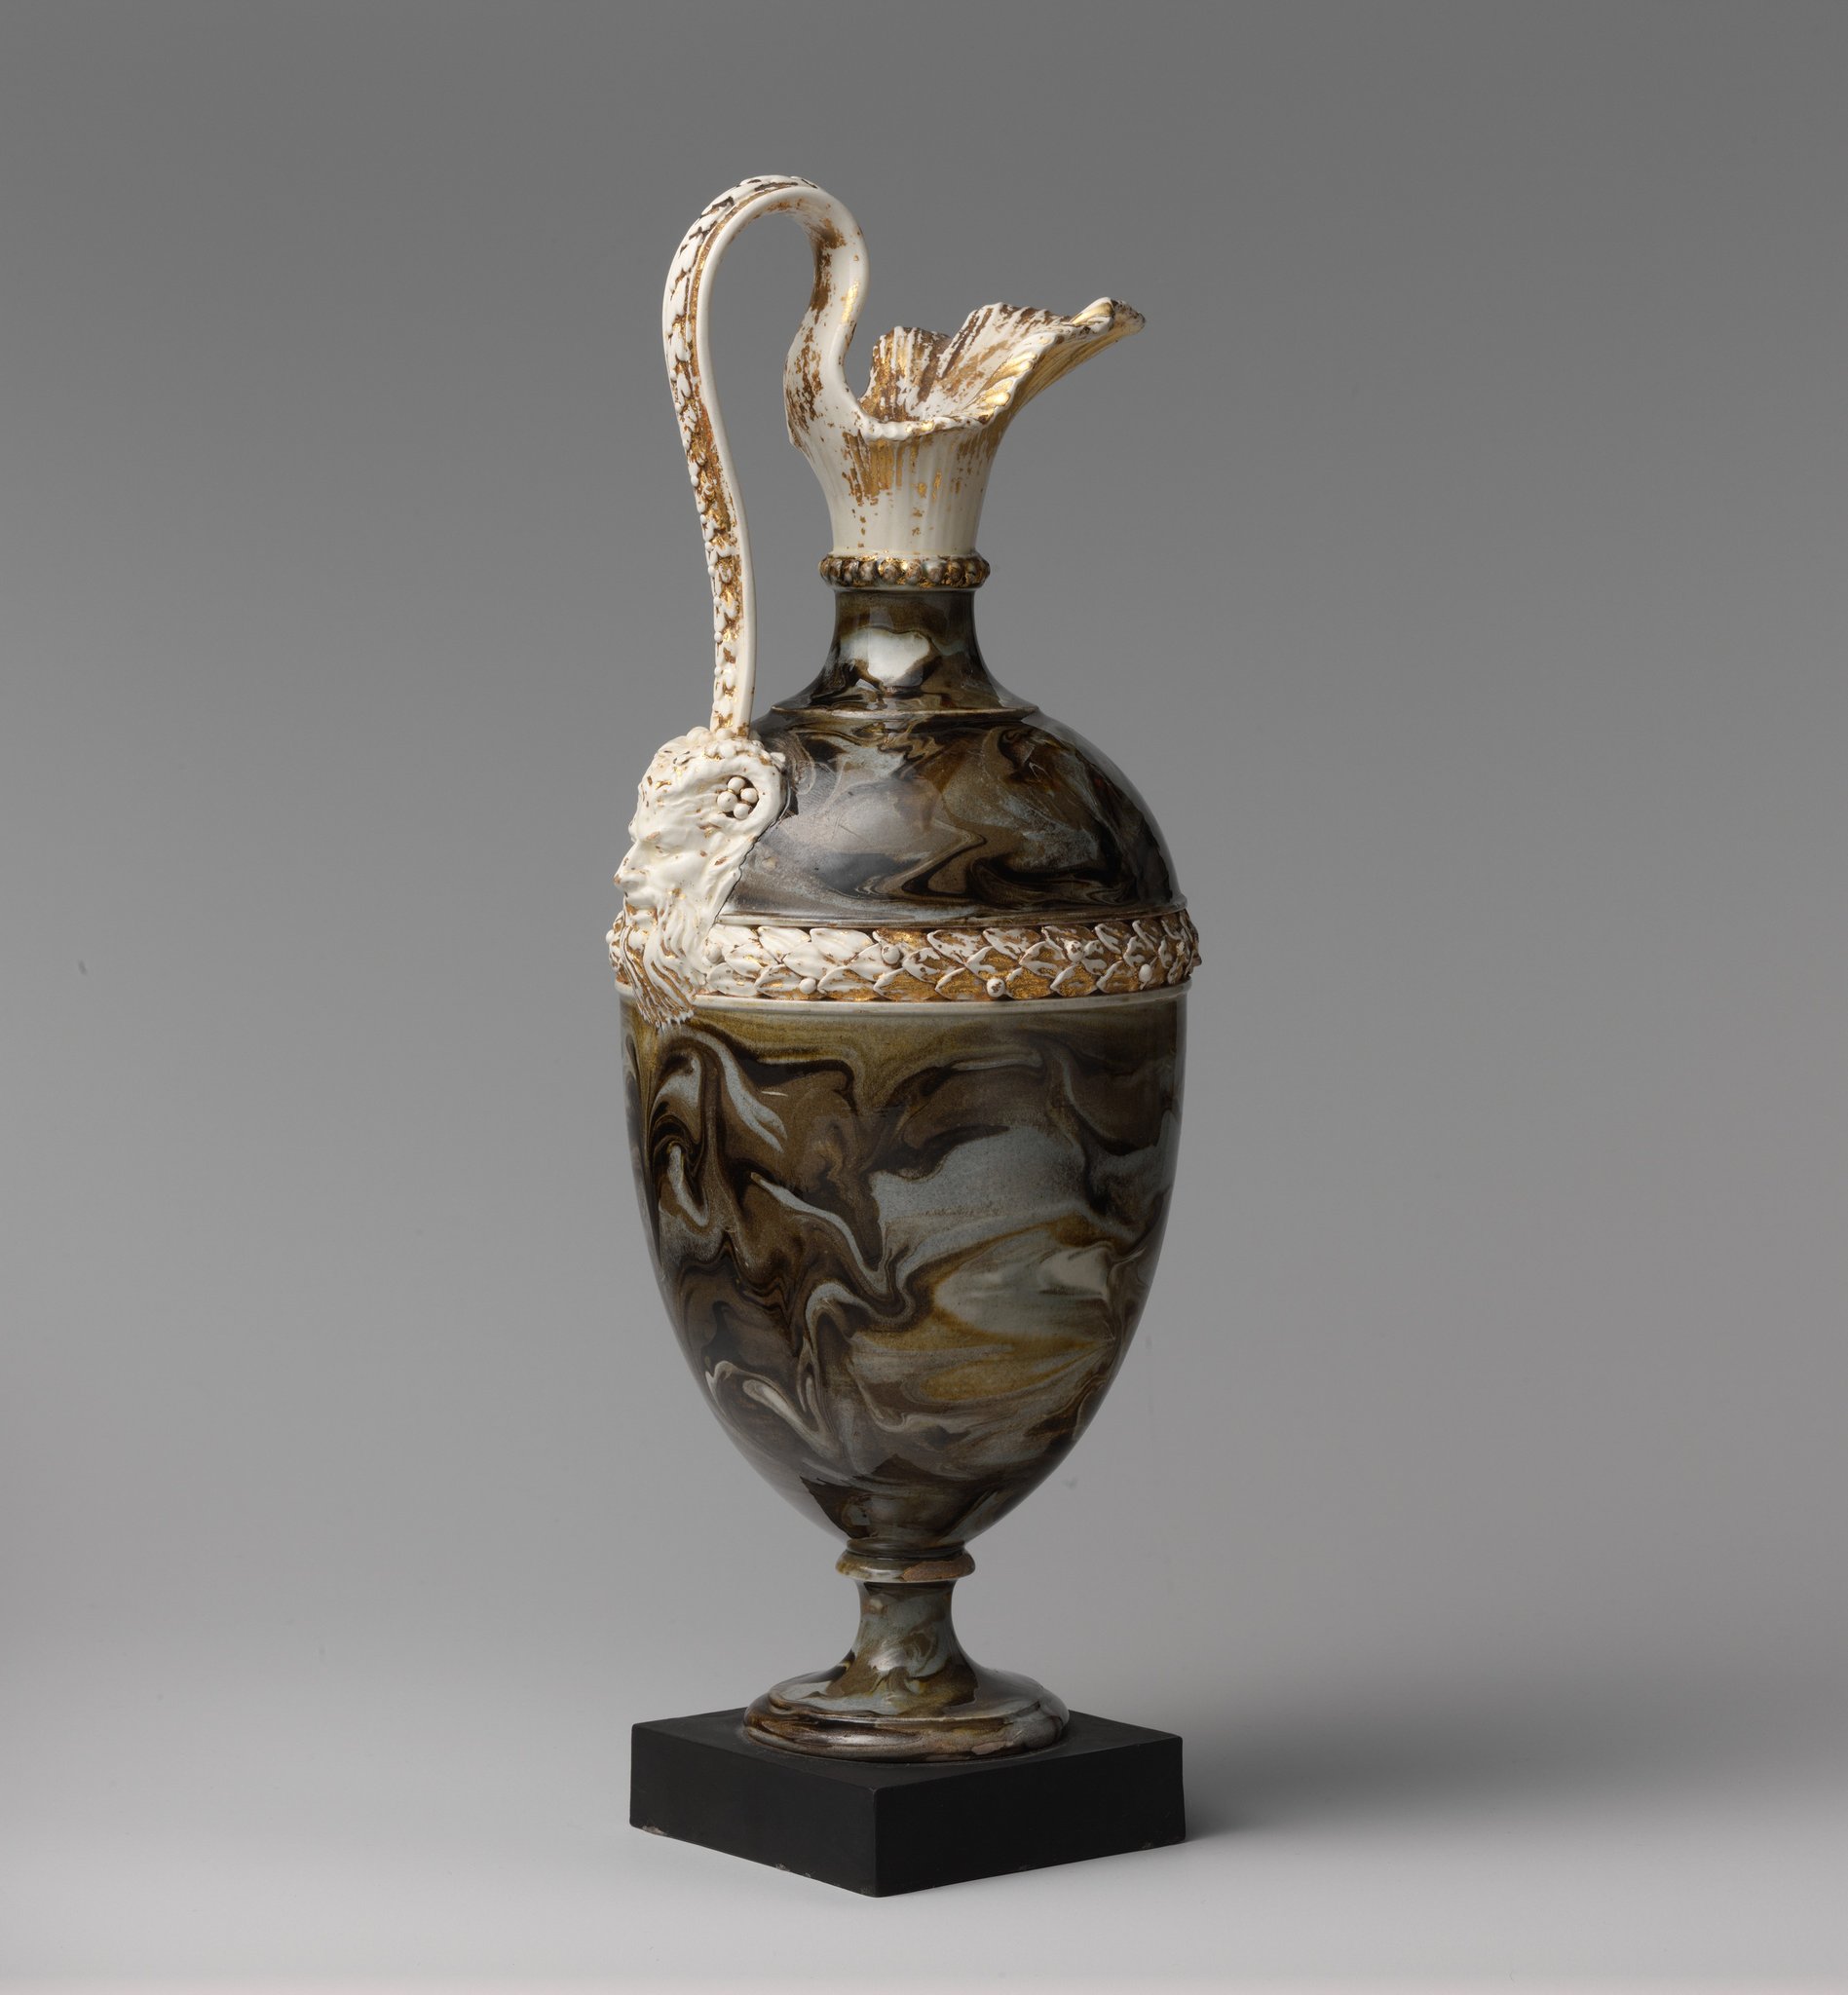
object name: ewer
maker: wedgwood and bentley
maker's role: factory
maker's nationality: british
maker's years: 1769-1780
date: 1769-1780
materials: creamware, glaze